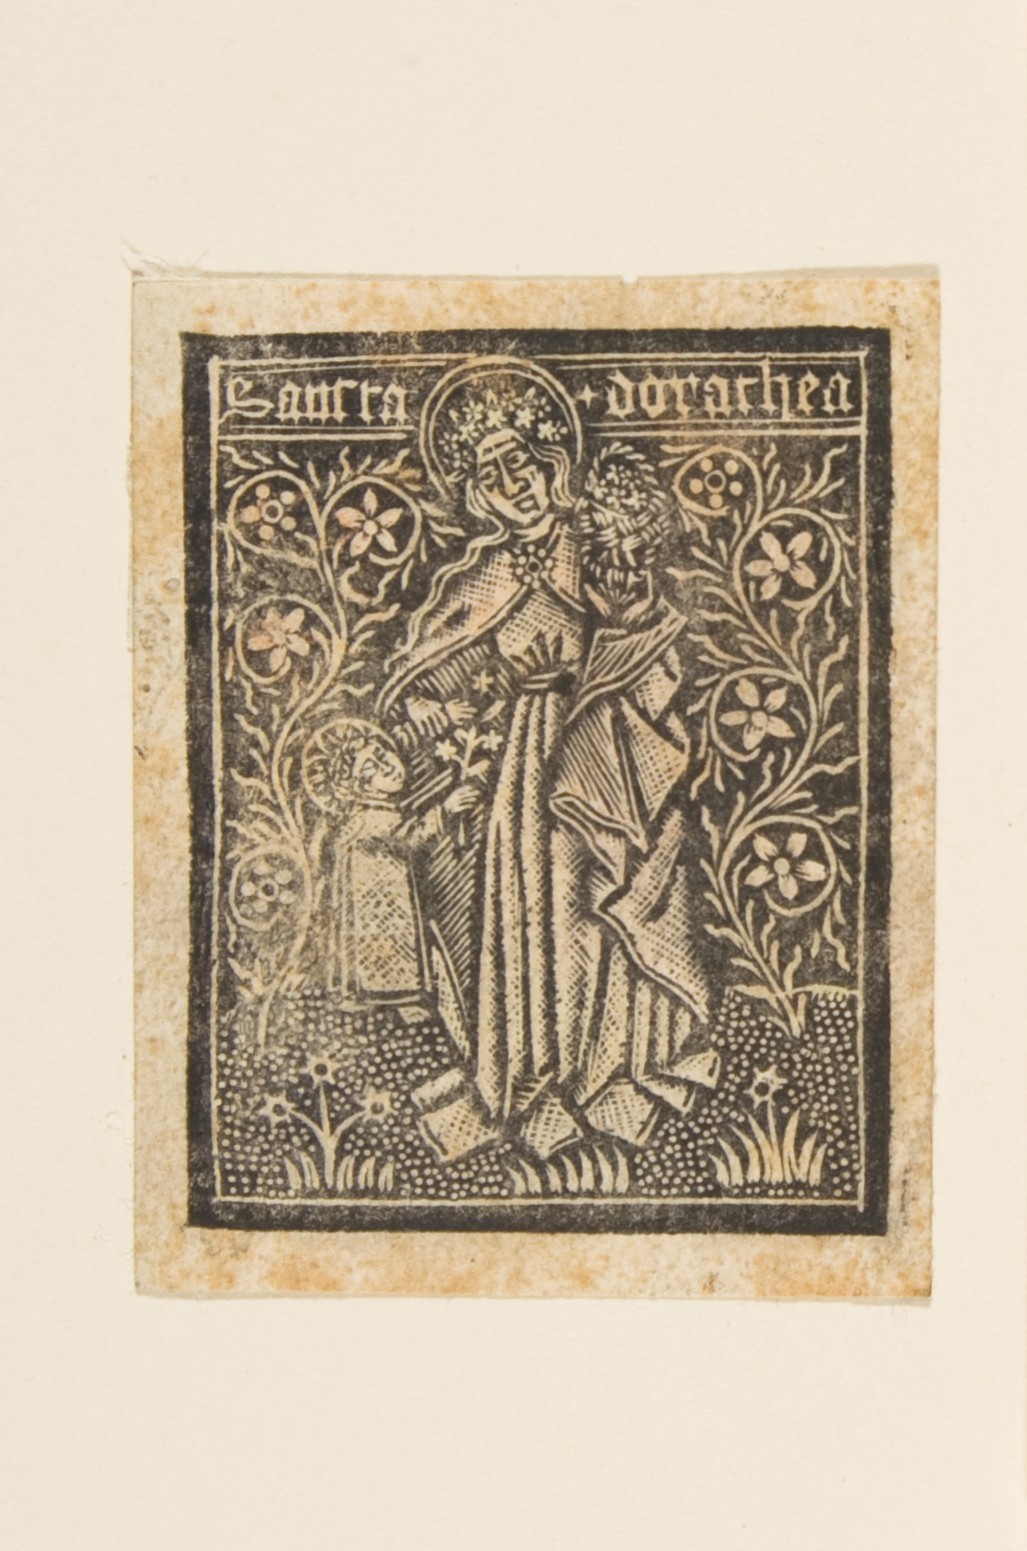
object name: print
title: St. Dorothy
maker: anonymous, german, 15th century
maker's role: artist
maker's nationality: german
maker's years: 1400-1500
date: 1401-1500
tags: children,women,saints